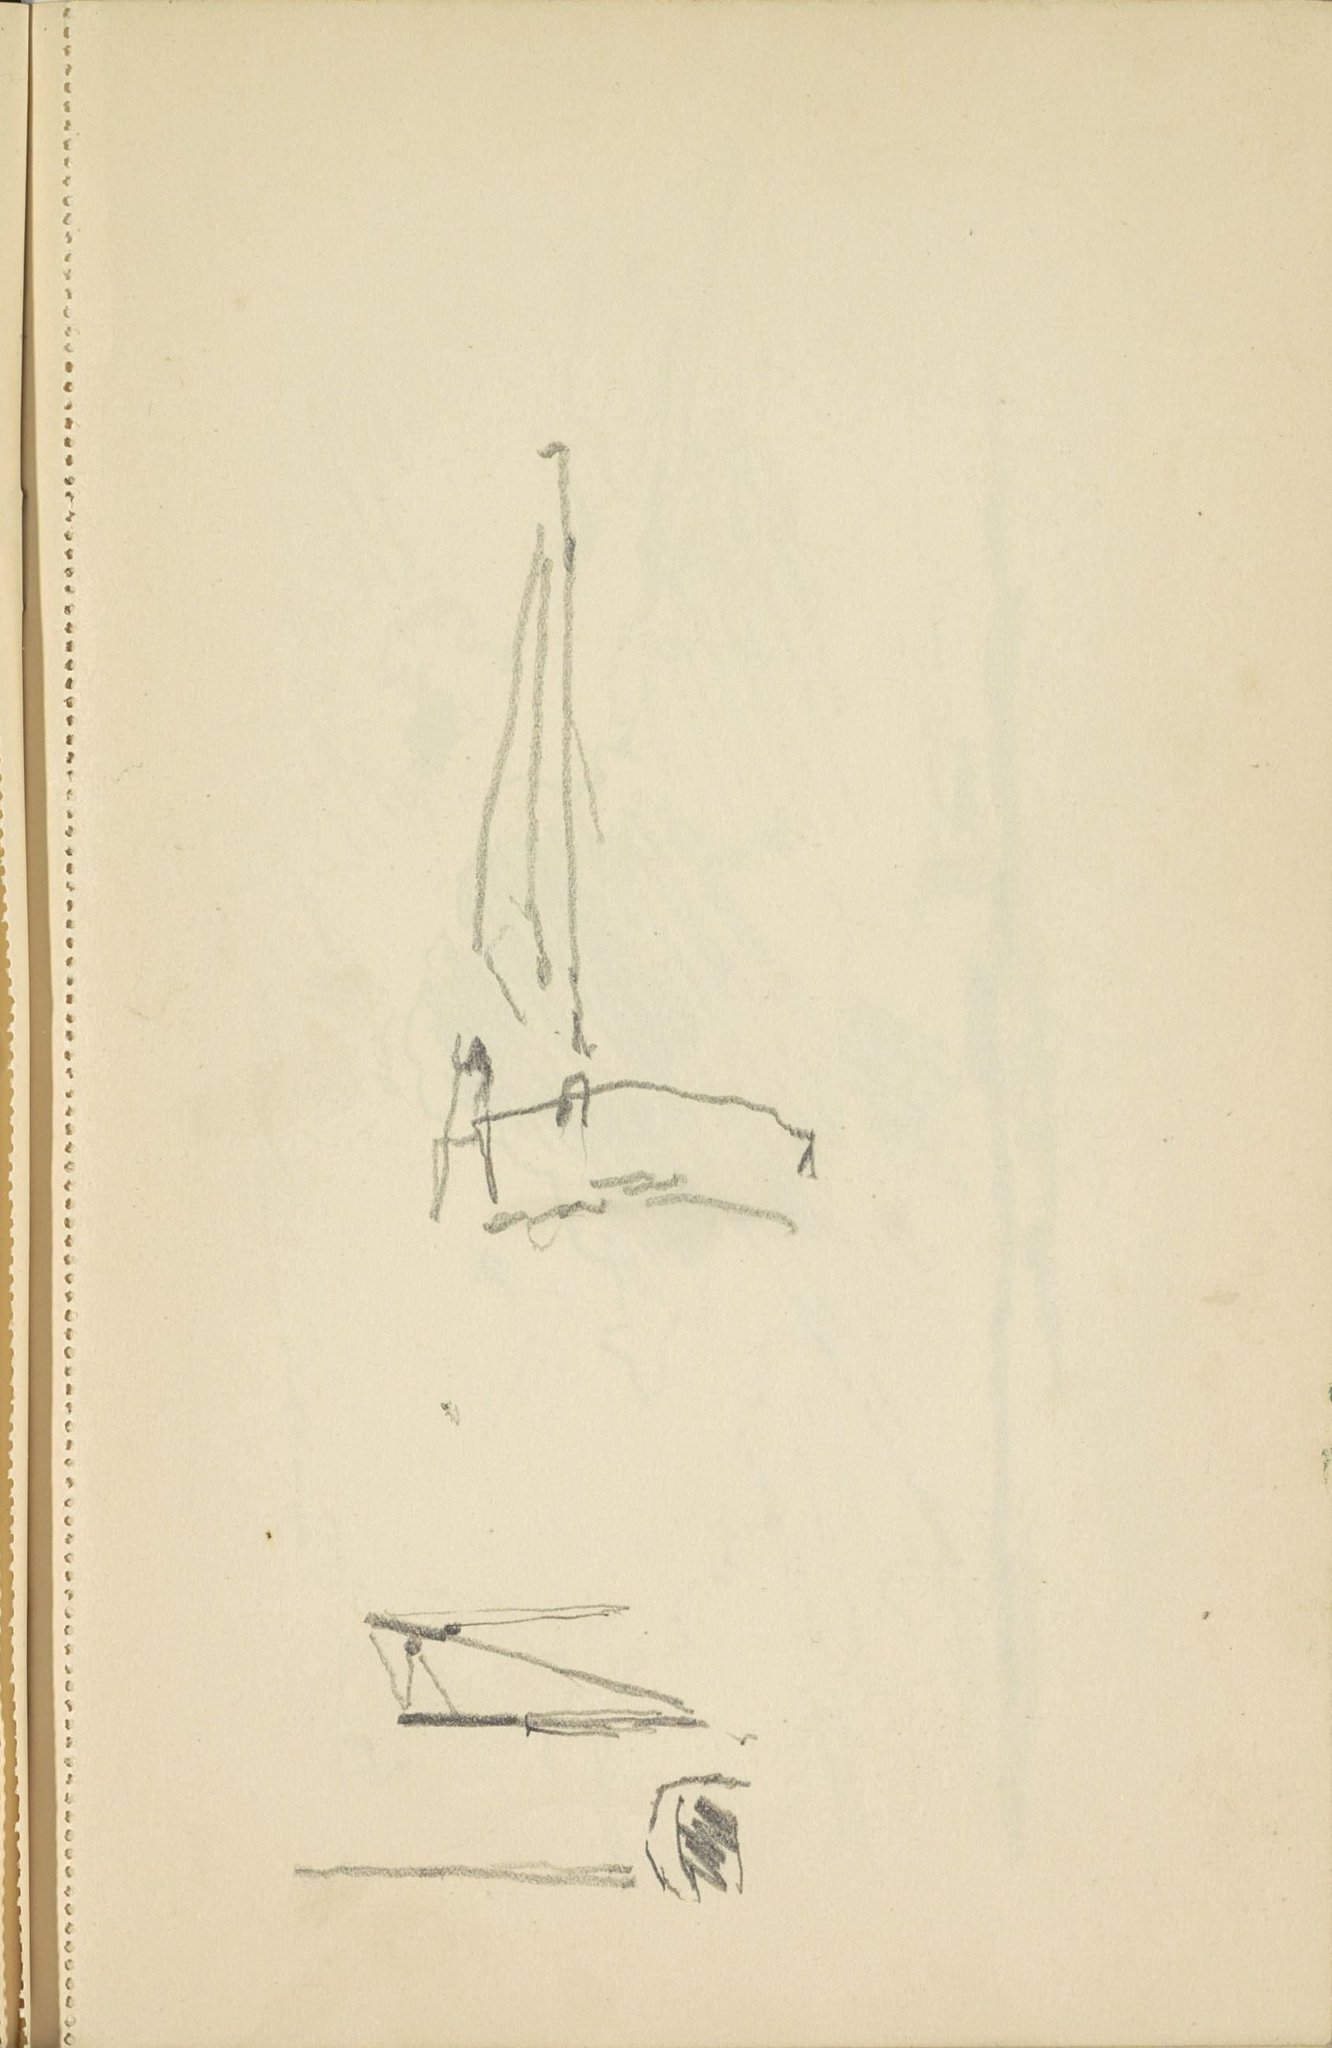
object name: sketchbook leaf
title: Zeilboot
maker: cornelis vreedenburgh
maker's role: draughtsman, print maker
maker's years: 1880-1946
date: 1890-1946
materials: paper, pencil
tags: sailing-ship, sailing-boat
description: Blad 49 recto uit een schetsboek met 73 bladen.